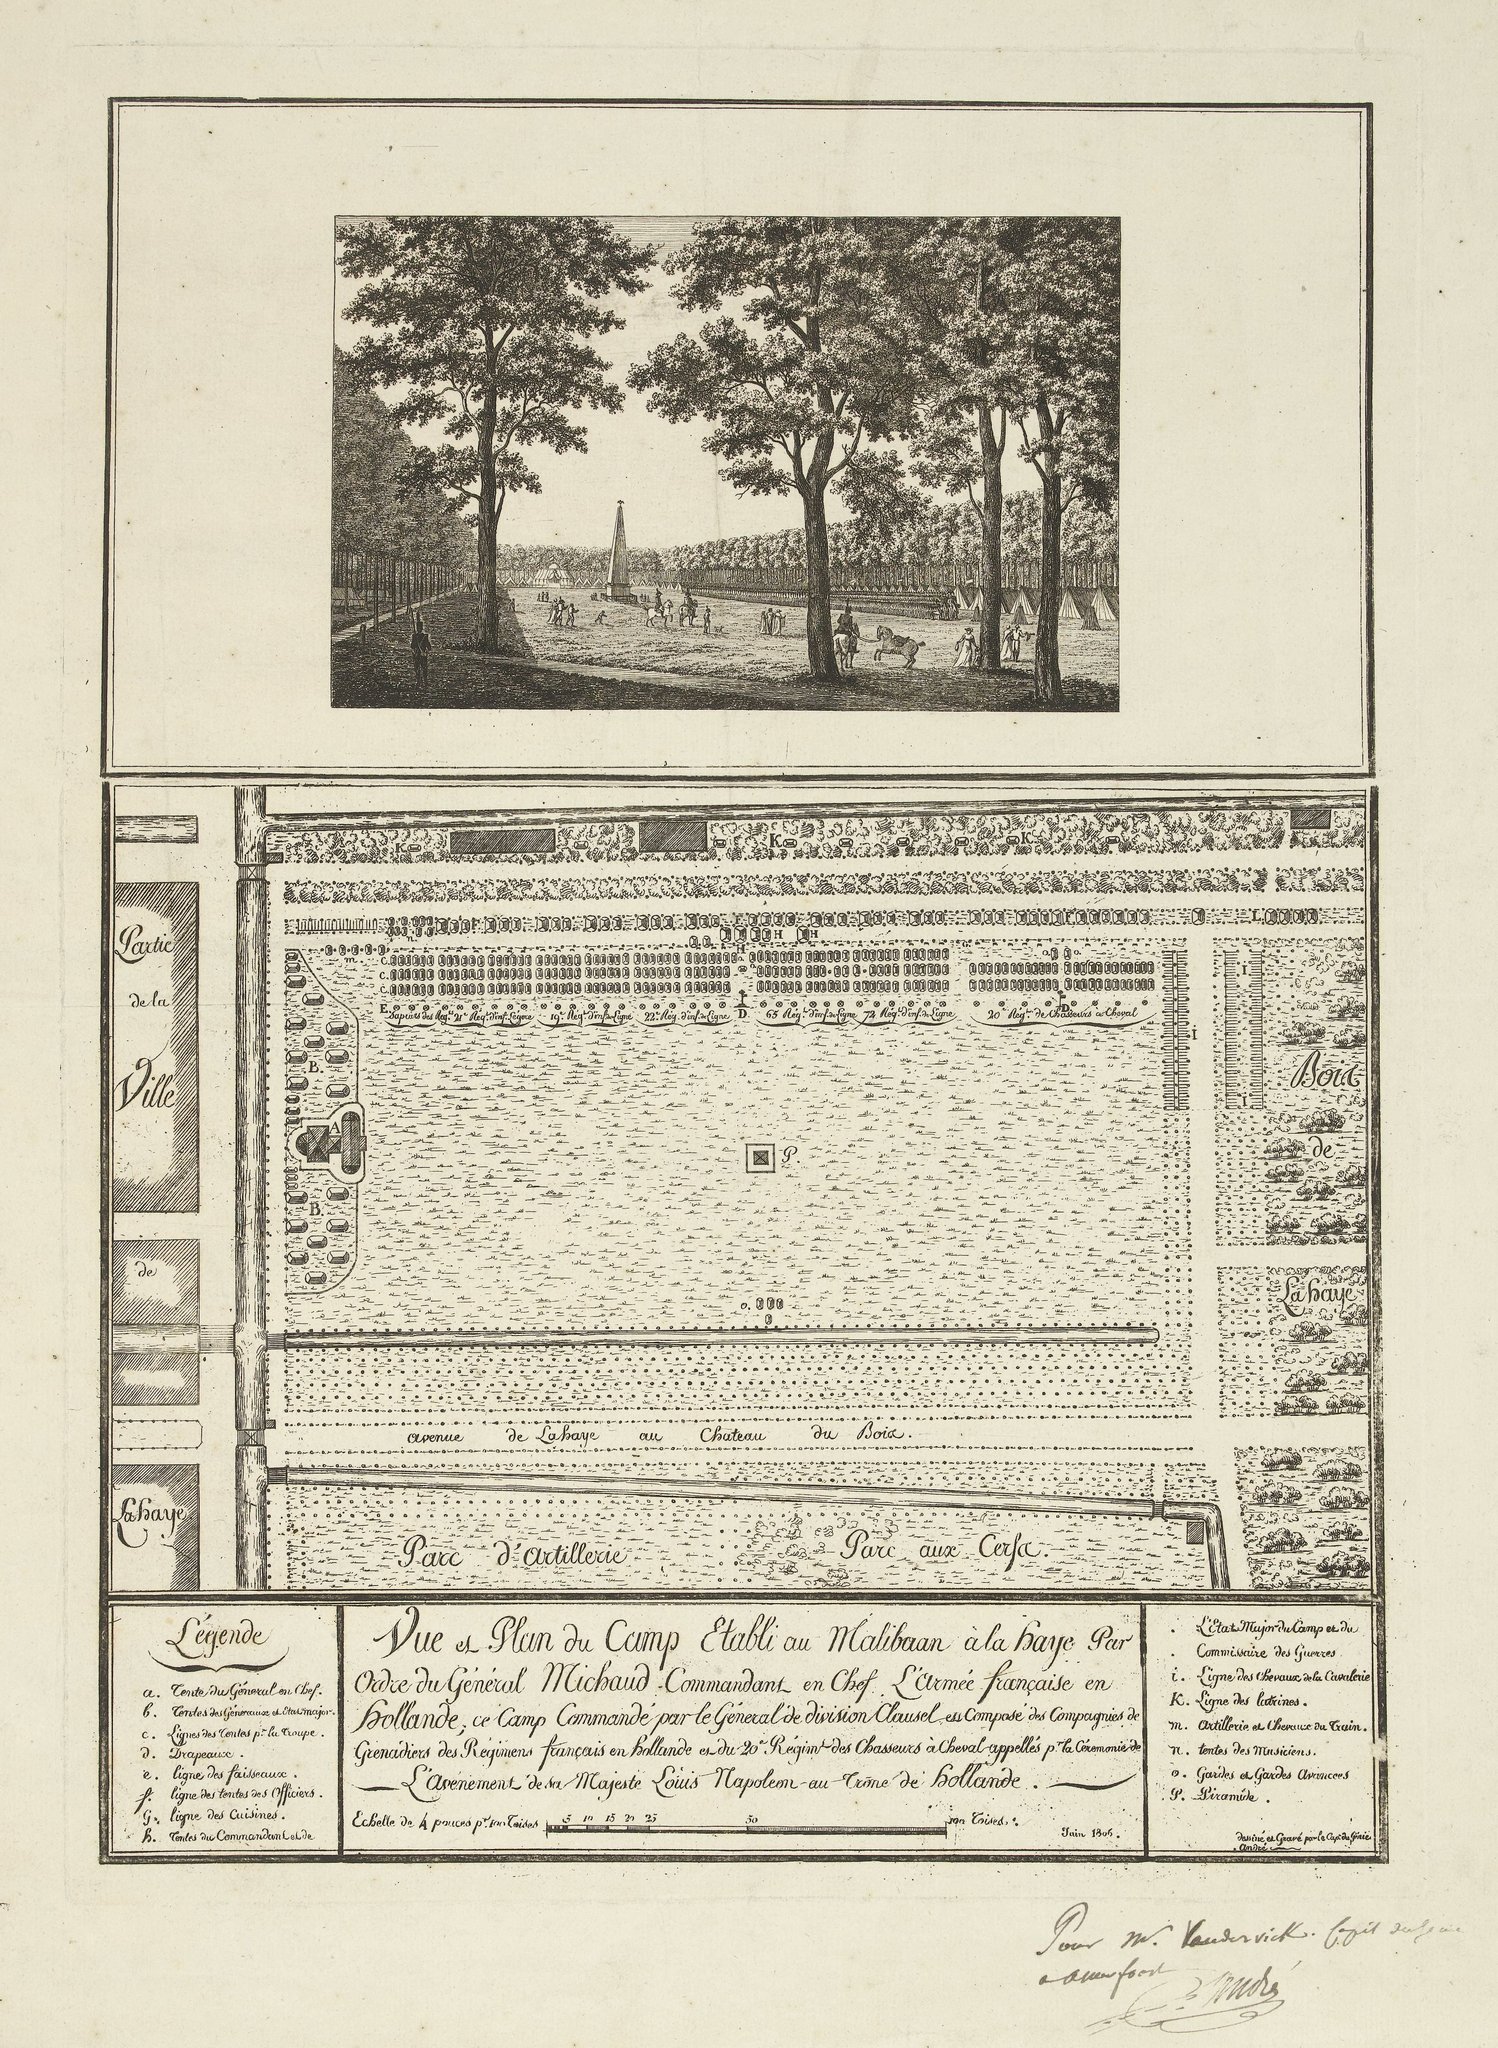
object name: print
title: Gezicht op het Franse kamp op het Malieveld te Den Haag ter eere van de troonsbestijging van Lodewijk Napoleon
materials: paper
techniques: etching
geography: amersfoort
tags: louis napoleon (king of holland), (military) camp with tents, the hague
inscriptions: dedication: ‘Pour M. Vandervick Capit. du genie / a Amersfoort / André’ opdracht, collector's mark: Lugt 2166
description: Gezicht op het Franse kamp op het malieveld in Den Haag. Onder de afbeelding een plan van het kamp met een legenda van a-p.